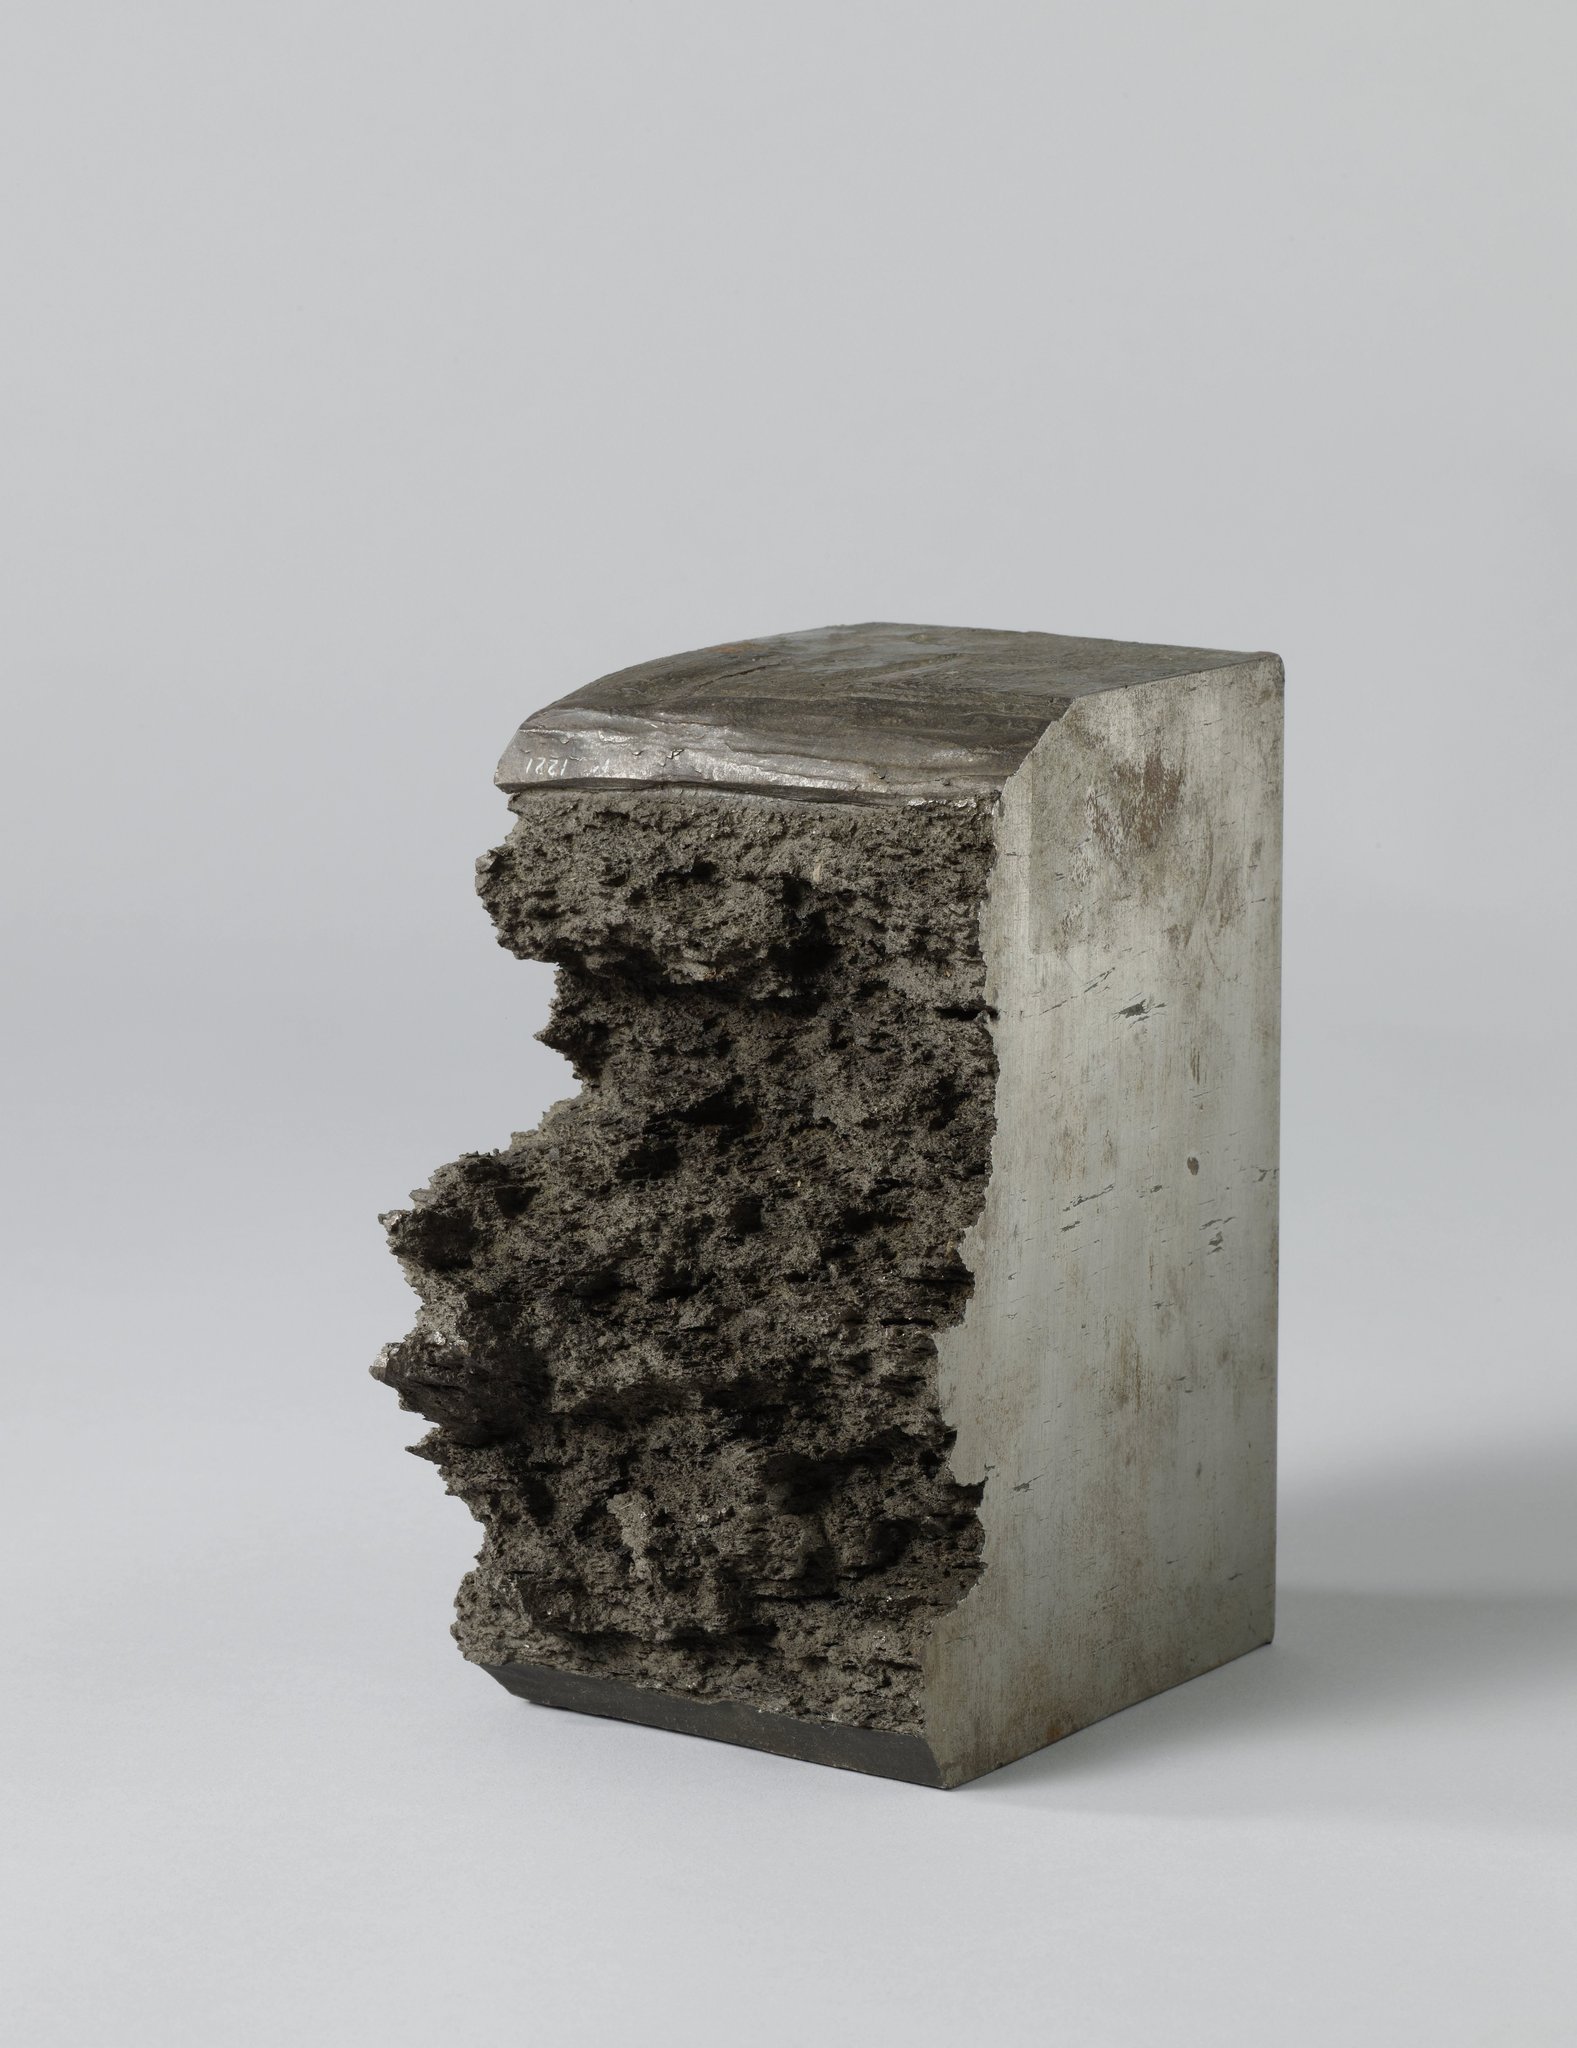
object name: armoured plate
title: Sample of armour plating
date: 1868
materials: iron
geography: sheffield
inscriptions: inscription, on the side: ‘SHEFFIELD / CHARLES / CAMELL & Co / LIMITED’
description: Monster van een pantserplaat van 6½ Engelse duim dikte. Twee kanten zijn afgezaagd en gepolijst, twee kanten zijn ruw en lijken afgebroken of gescheurd; de twee overblijvende, tegenover elkaar liggende vlakken zijn van de vlakke zijden van de pantserplaat, aangezien zij 6½ Engelse duim dikte aangeven.